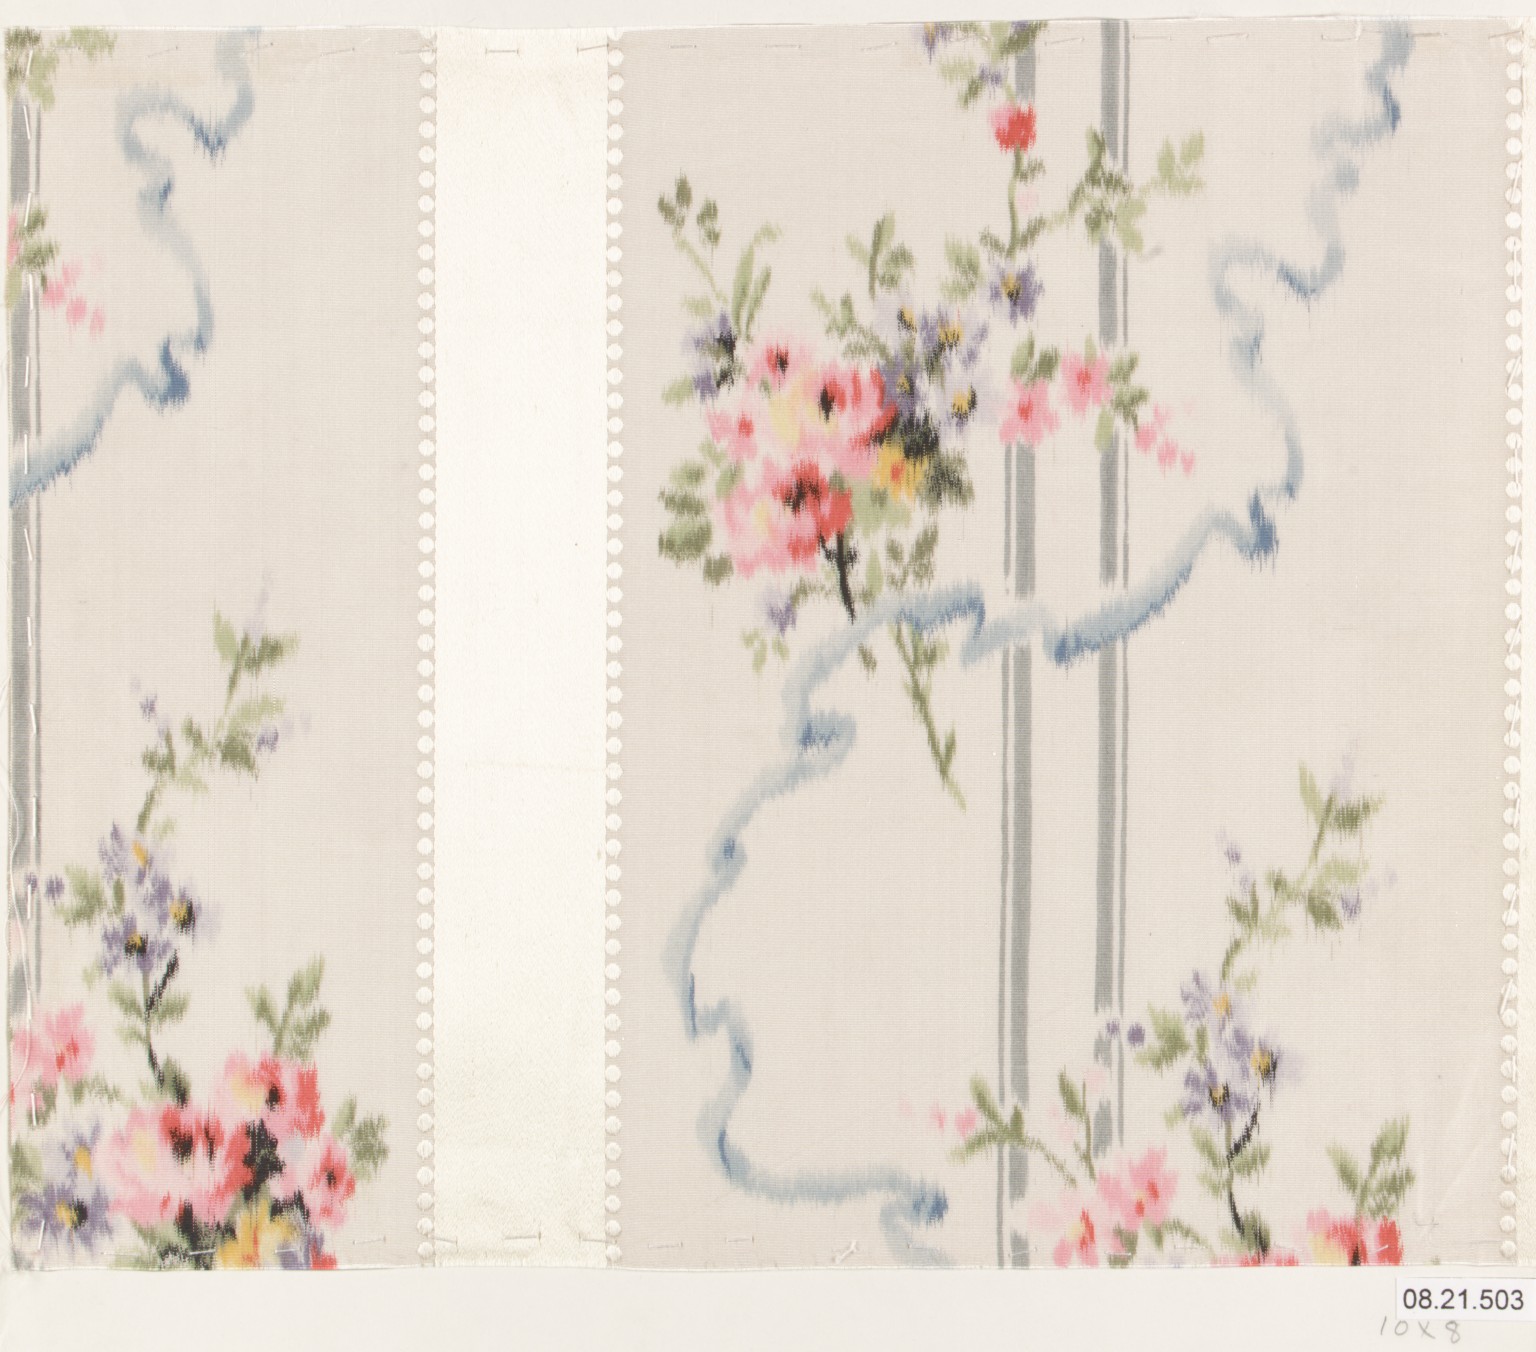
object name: textile sample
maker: Anonymous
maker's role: designer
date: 1900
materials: silk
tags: flowers